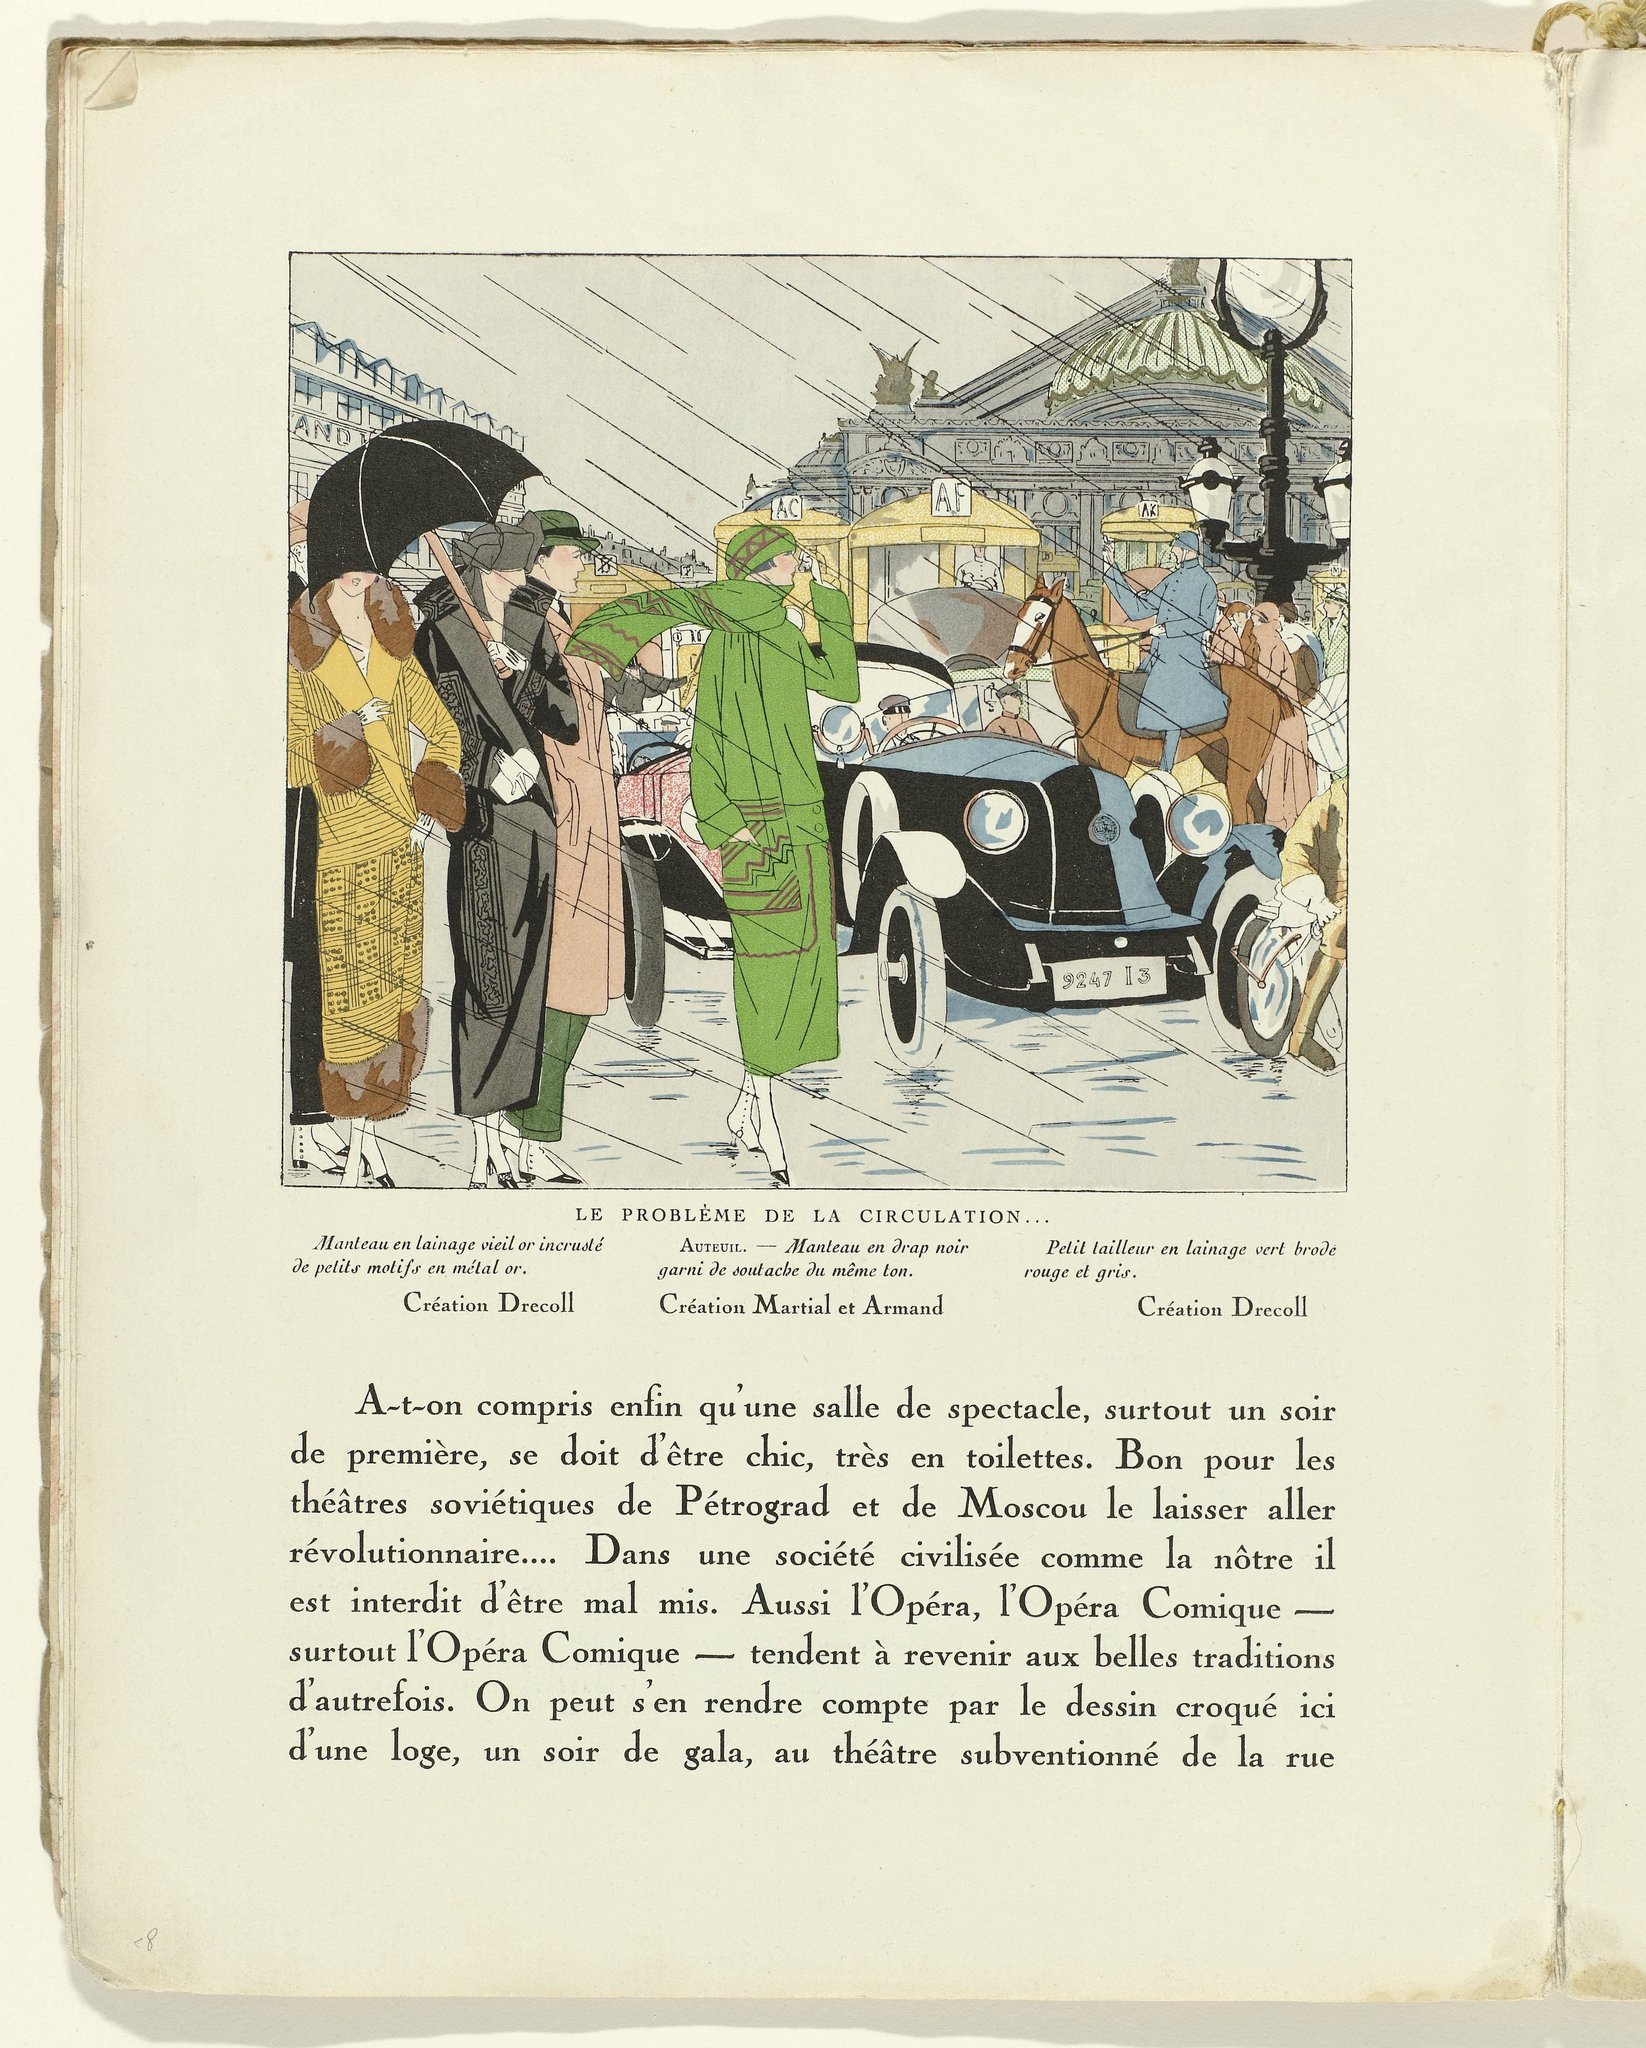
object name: magazine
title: Art - Goût - Beauté, Feuillets de l' élégance féminine, Janvier 1924, No. 41, 4e Année, p. 8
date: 1924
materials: paper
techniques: hand coloring, lithograph, pochoir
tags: downpour, rain shower, traffic regulation (signs, lights, etc.), ensembles of pieces of clothing (suit) (+ women's clothes), umbrella (+ women's clothes), coat (+ women's clothes), fashion plates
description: Tekst met illustratie van stadsbeeld met auto's en voetgangers in de regen: ' Le problème de la circulation...' Drie vrouwen in mantels van Martial et Armand en Drecoll. Pagina uit het modetijdschrift Art-Goût-Beauté (1920-1933).